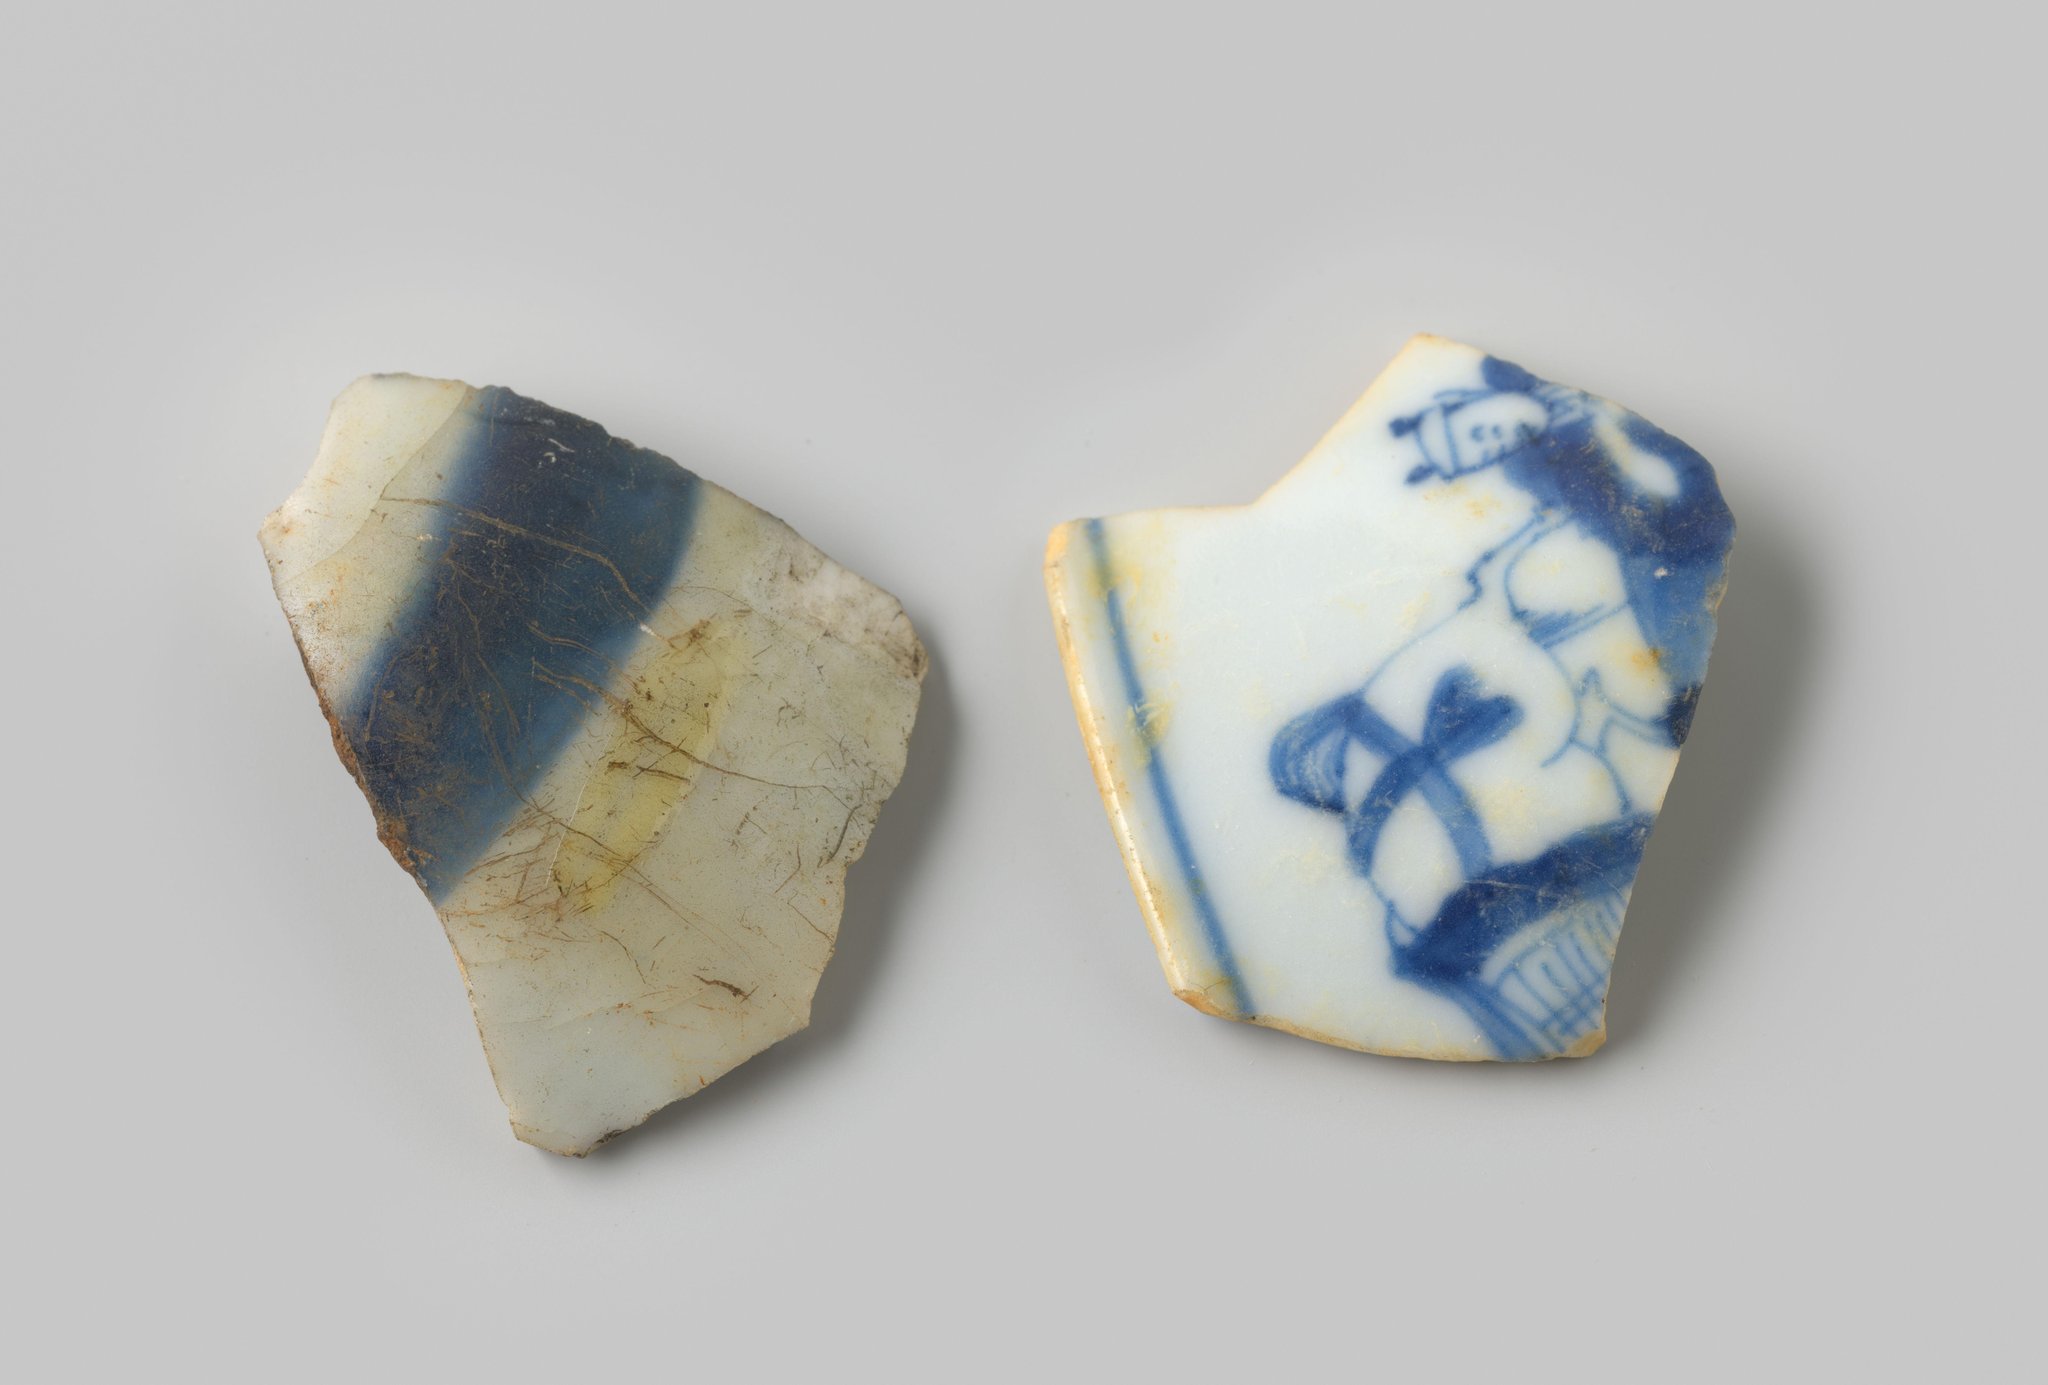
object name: sherd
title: Porseleinen scherven uit het wrak van de Oost-Indiëvaarder Hollandia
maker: Anonymous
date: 1700-1743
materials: porcelain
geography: netherlands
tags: verenigde oostindische compagnie, hollandia (schip), annet